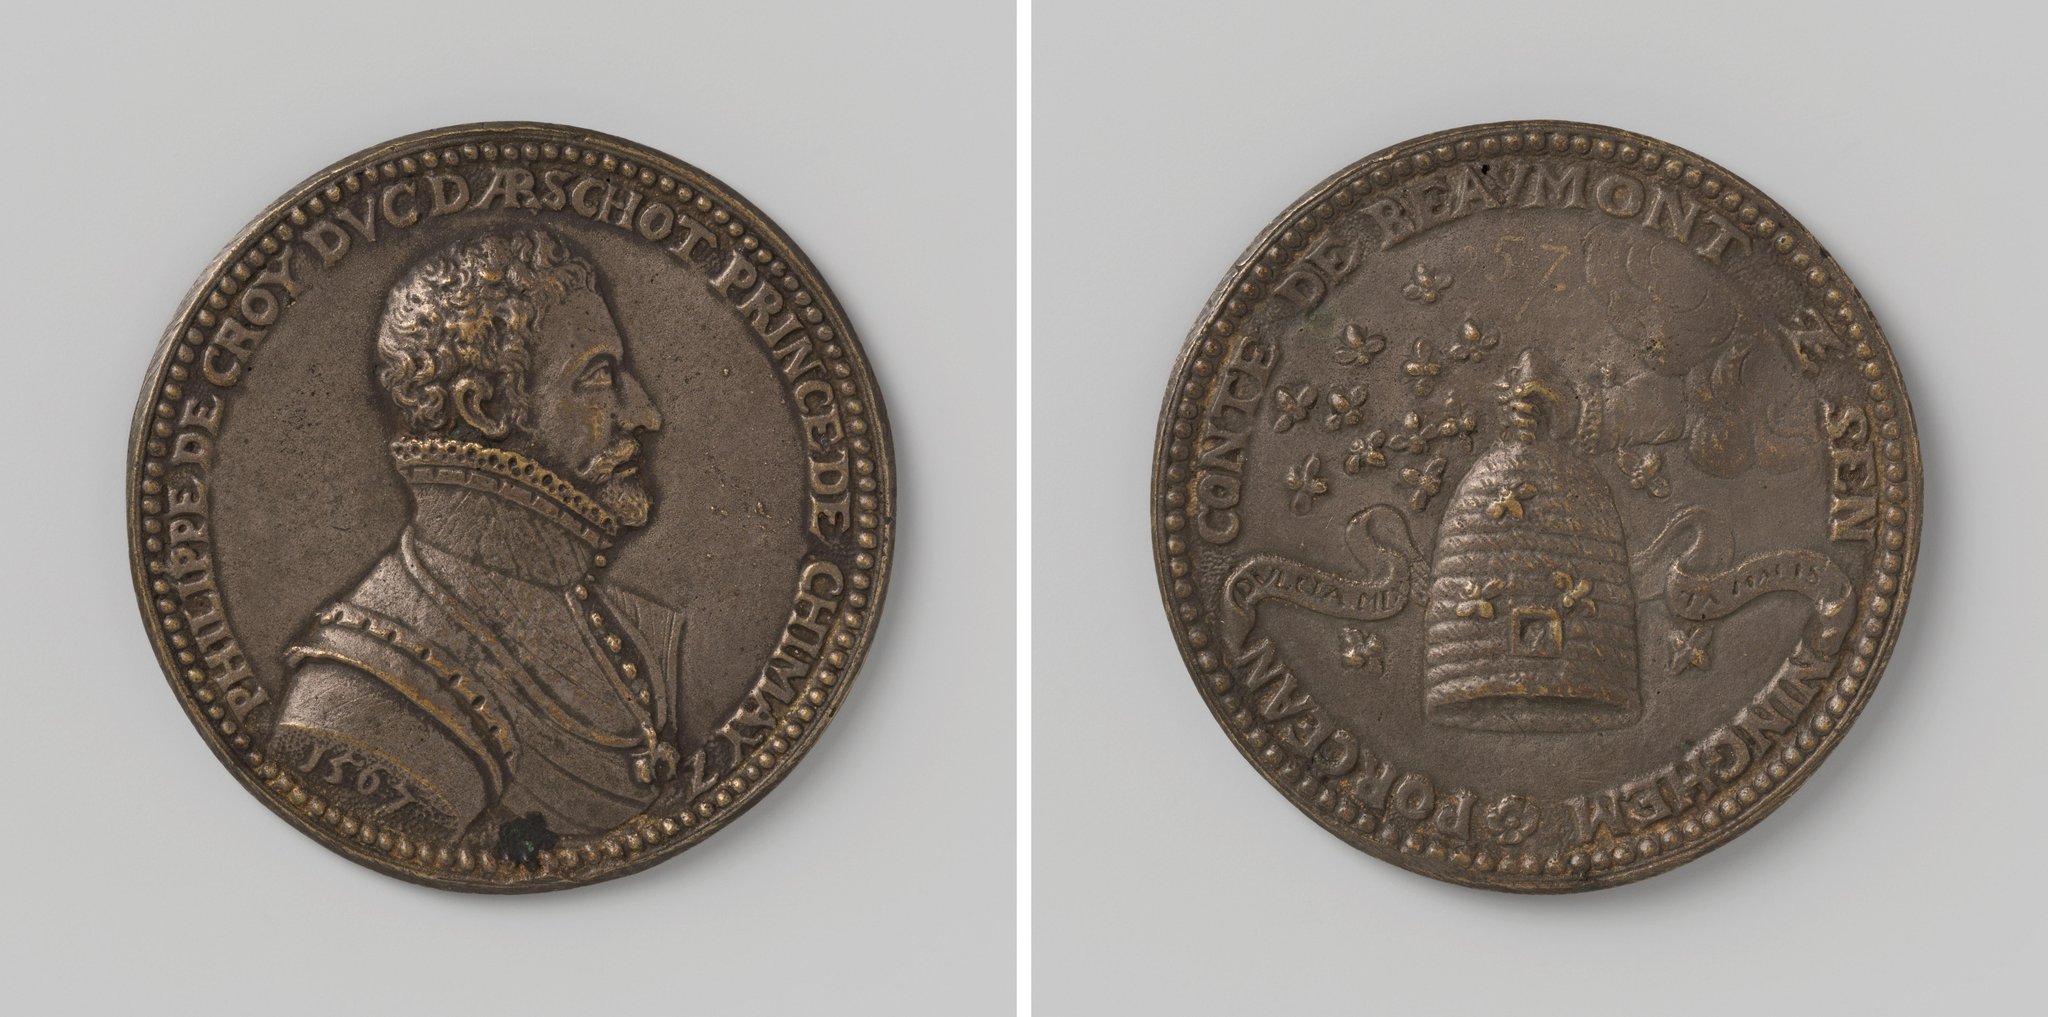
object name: jeton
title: Filips van Croy, hertog van Aarschot, prins van Chimay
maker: jacques jonghelinck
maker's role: medailleur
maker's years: 1530-1606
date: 1567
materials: bronze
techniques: casting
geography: antwerp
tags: venice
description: Bronzen penning. Voorzijde: borststuk man binnen omschrift. Keerzijde: hand uit wolken houdt bijenkord vast, omwonden met wimpel met opschrift binnen omschrift.